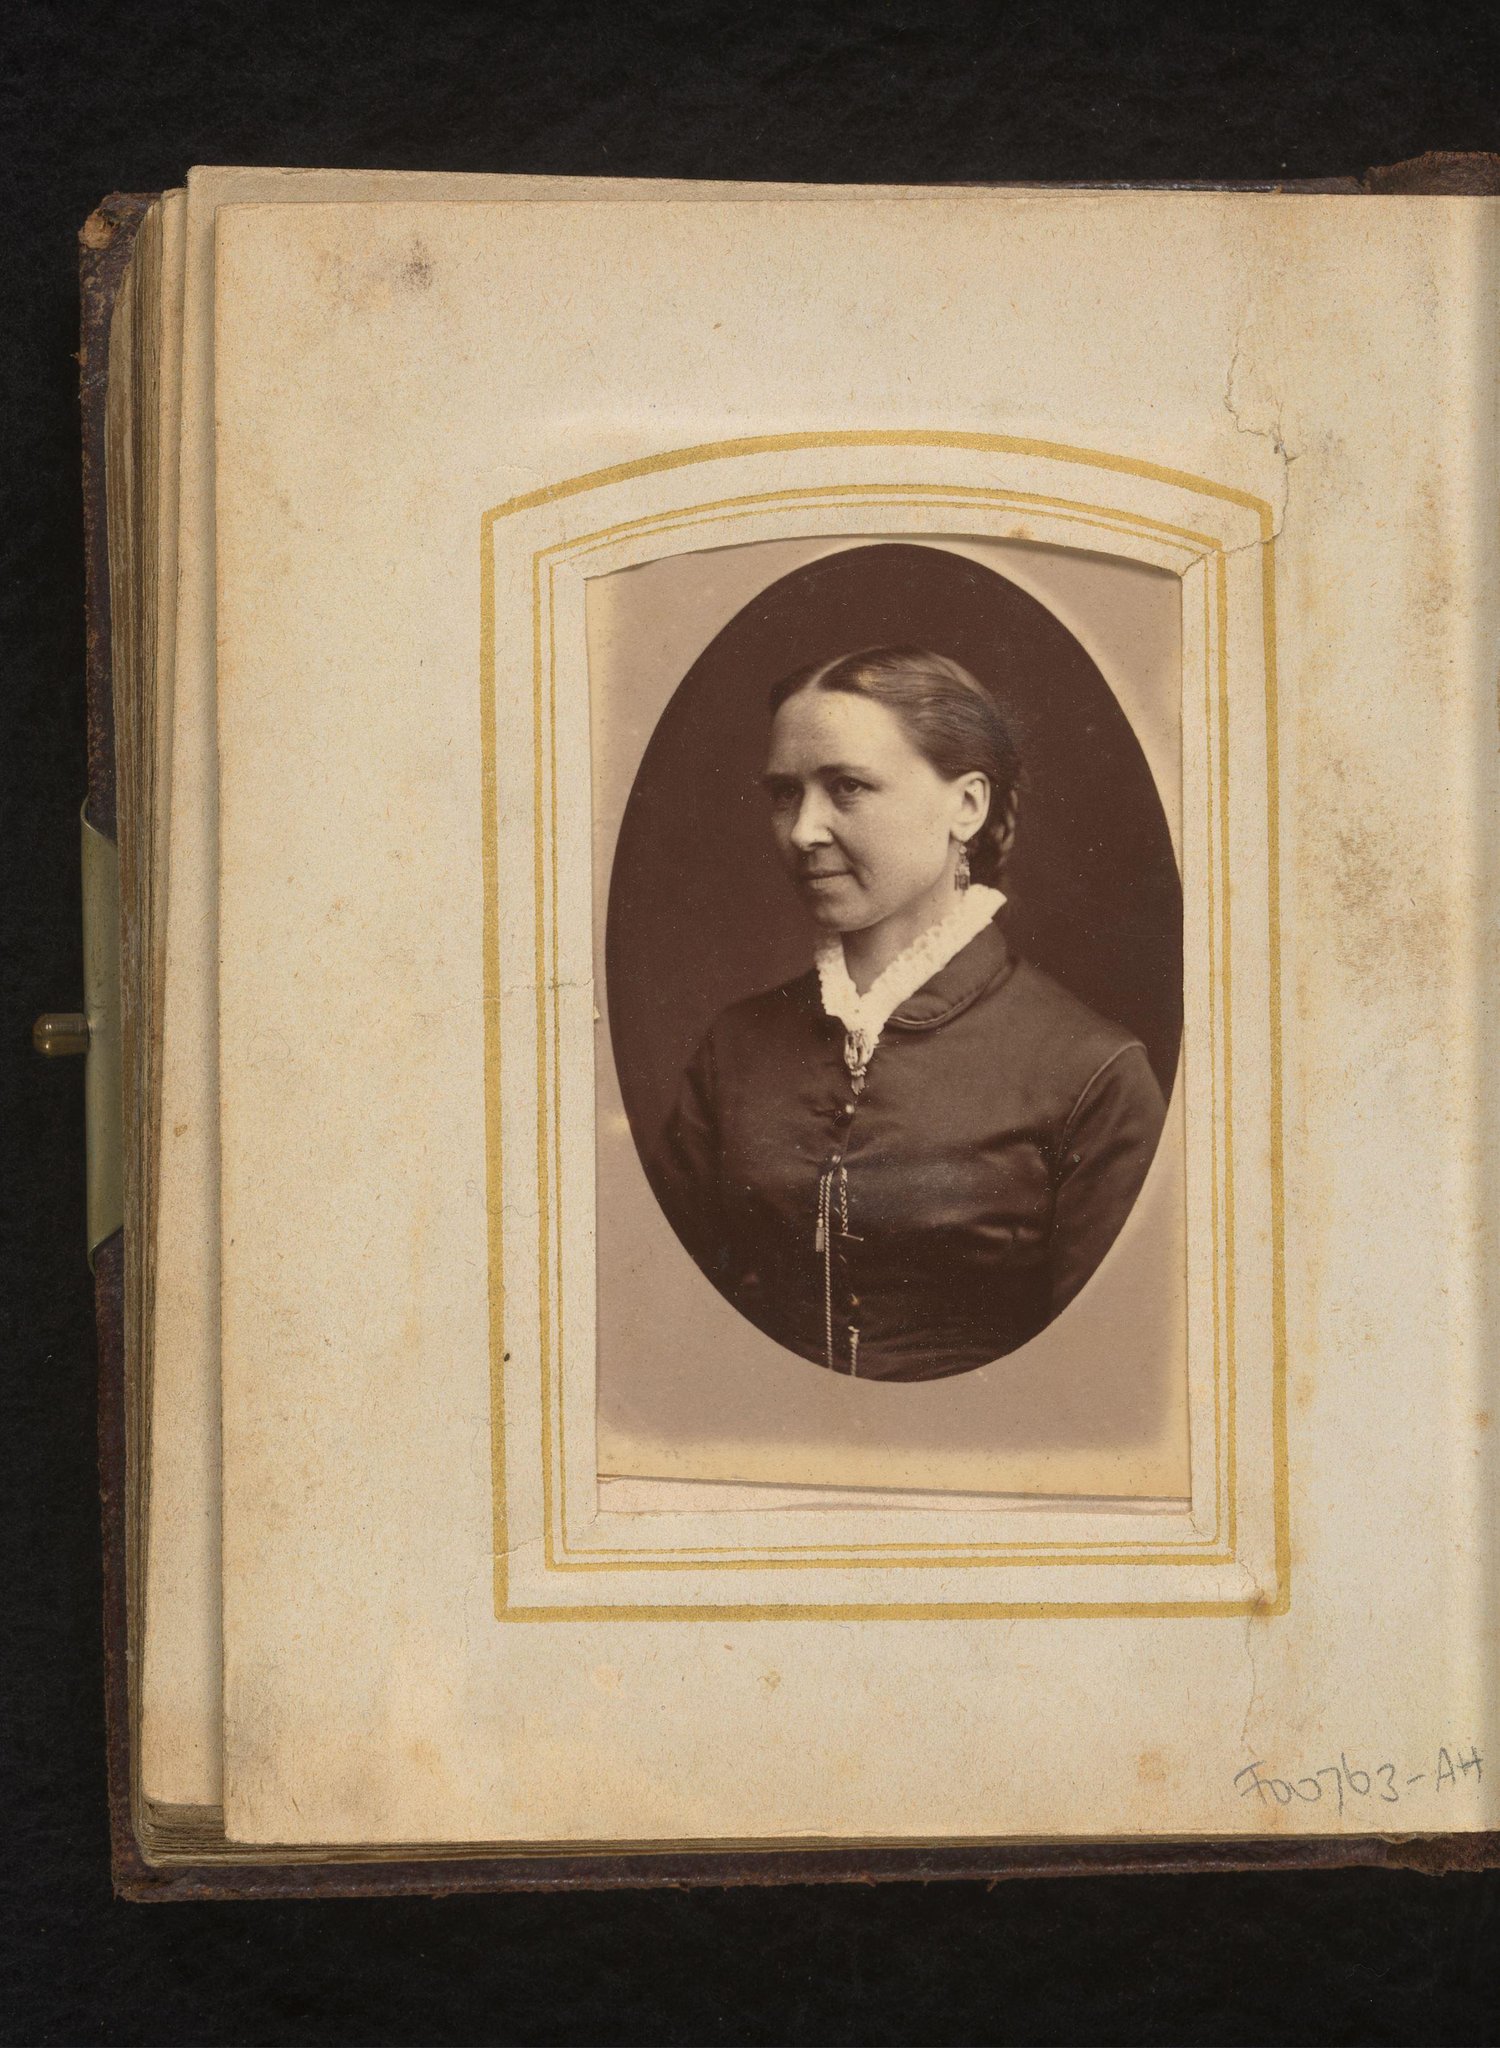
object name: carte de visite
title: Portret van een vrouw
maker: willem gerhardus kuijer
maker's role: fotograaf, hoffotograaf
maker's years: 1834-1899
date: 1862-1899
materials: cardboard, photographic support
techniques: albumen print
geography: amsterdam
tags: historical persons - bb - woman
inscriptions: inscription: ‘W. G. KUIJER/ Photograaph/ Amsterdam/ Rozengracht 72.’